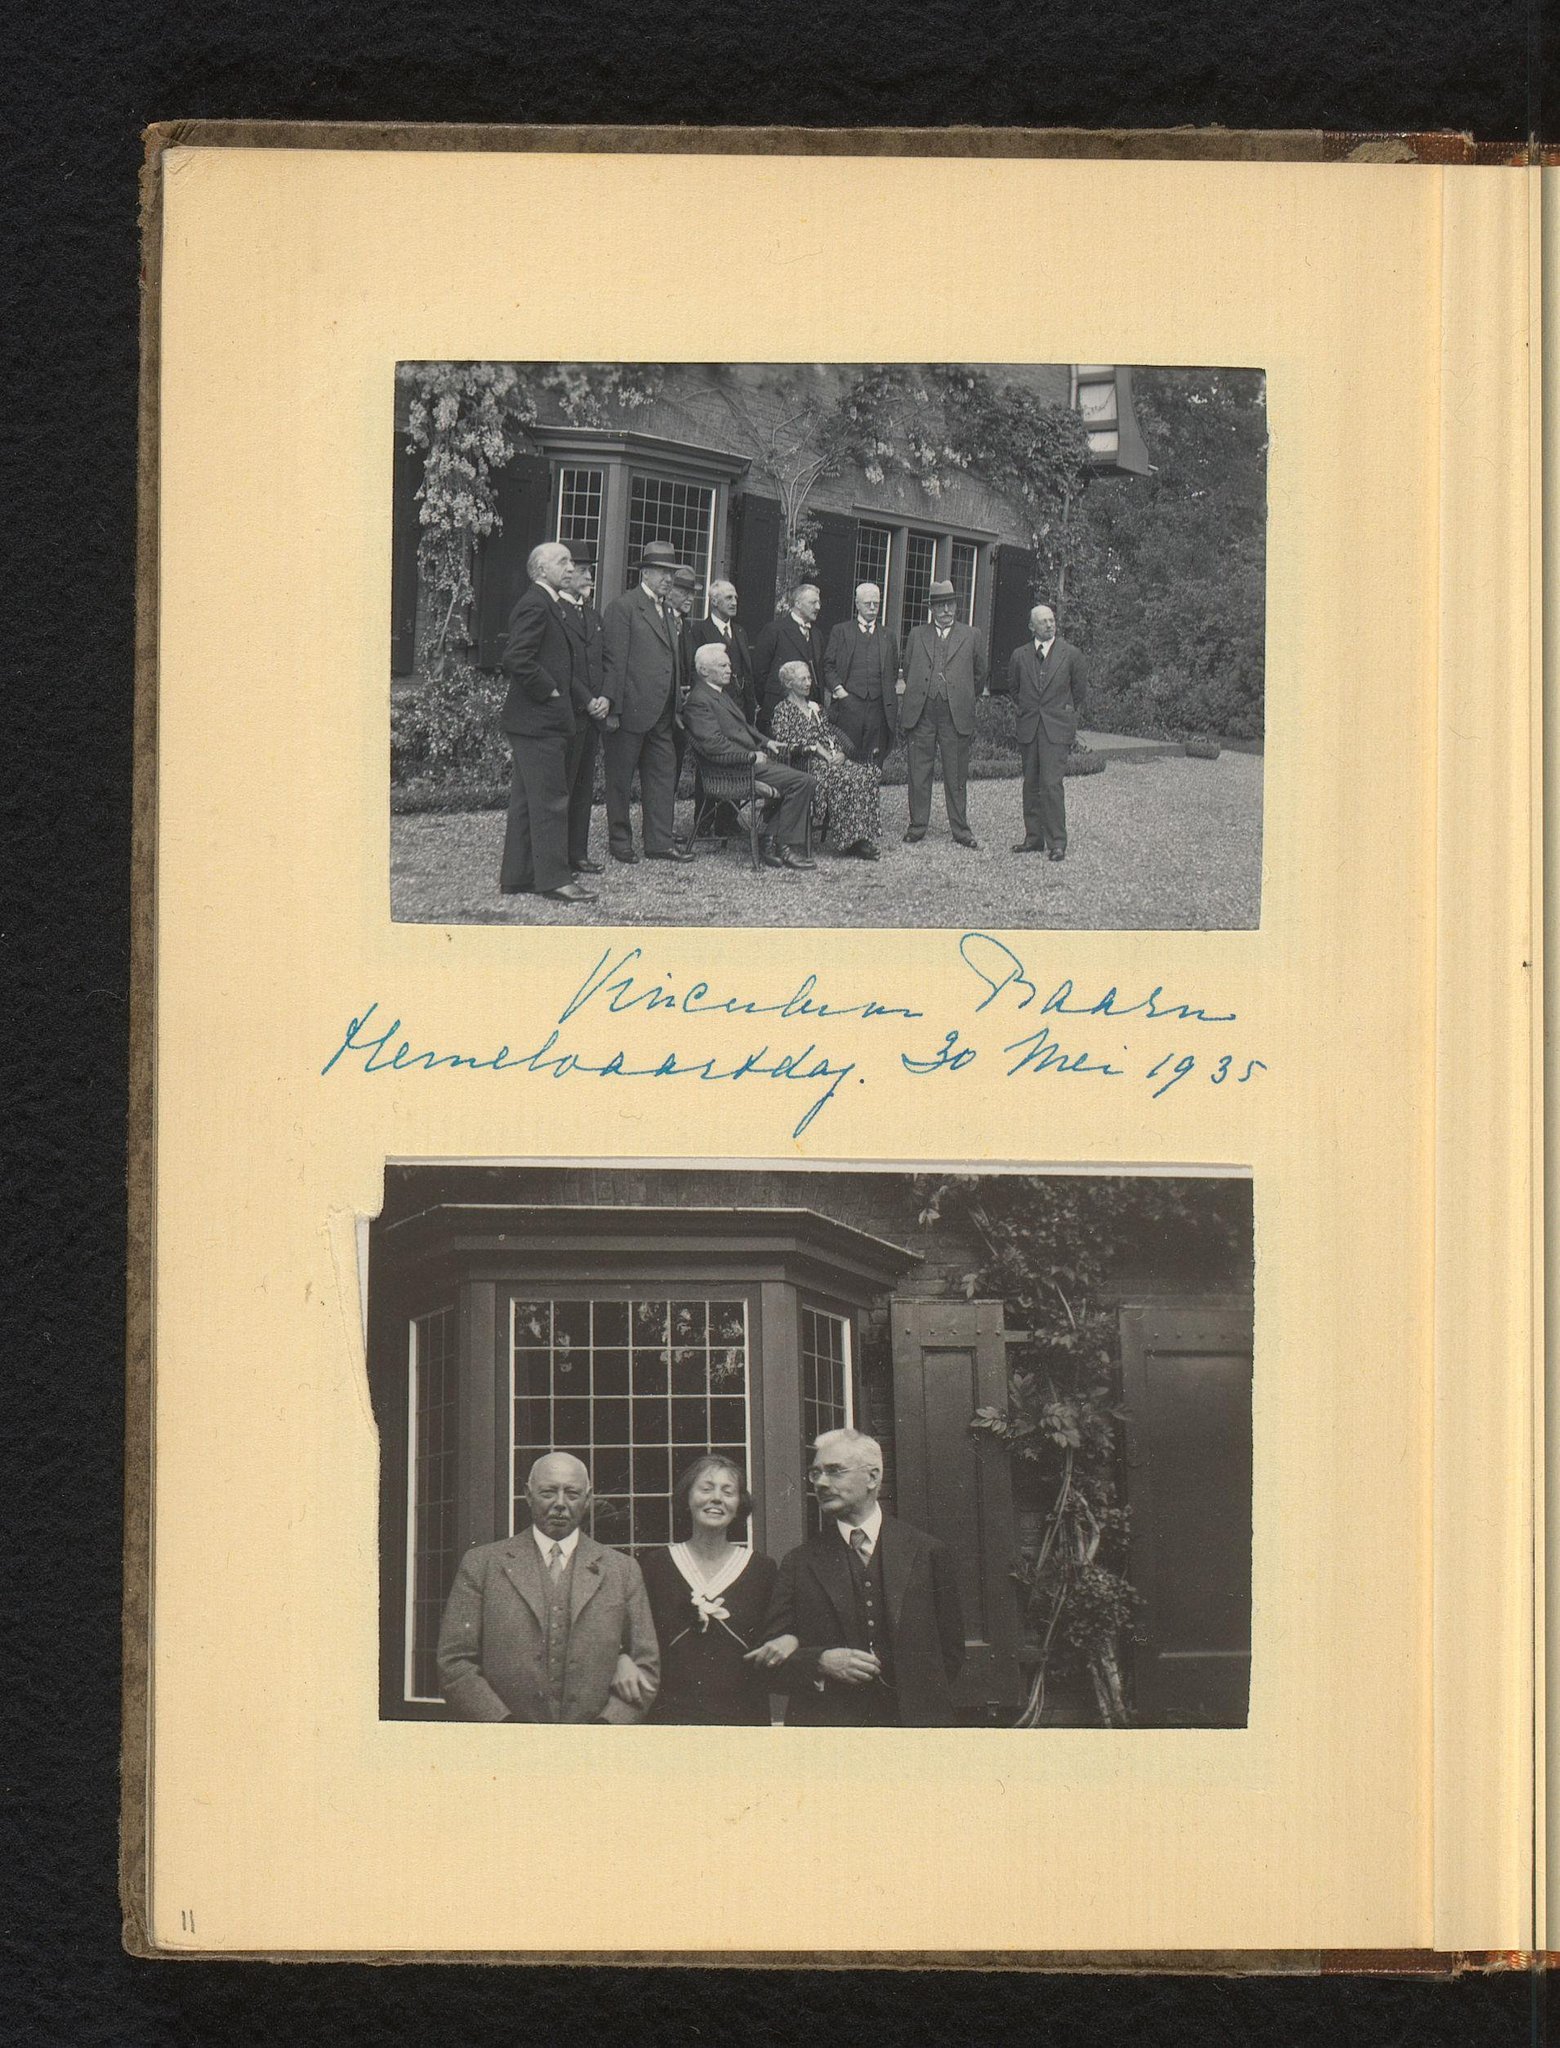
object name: photograph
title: Twee groepsportretten te Baarn, van het gezelschap Vinculum Scientiarum en van andere mensen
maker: Anonymous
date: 1935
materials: paper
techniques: gelatin silver print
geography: baarn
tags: arm in arm (friends), group of professors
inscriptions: inscription: ‘Vinculum Baarn/ Hemelvaartsdag. 30 Mei 1935’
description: Deze foto's maken deel uit van een album.